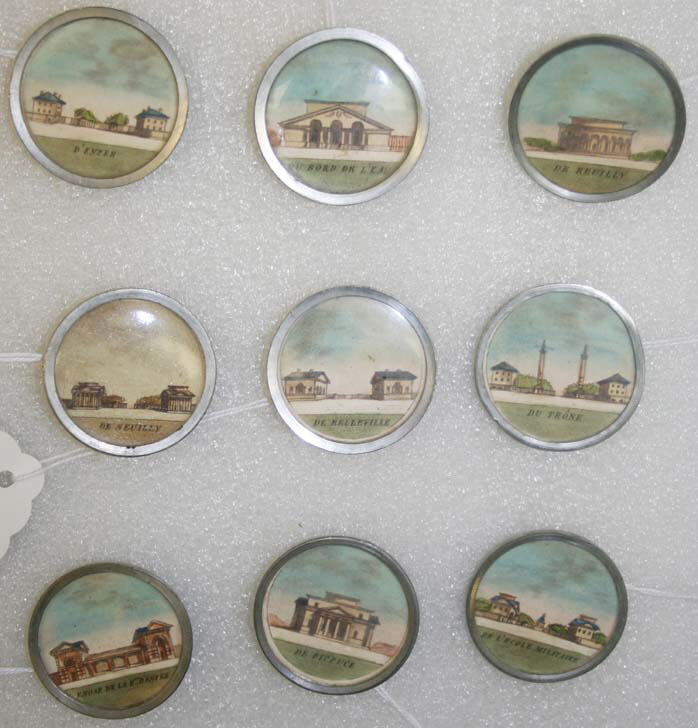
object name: button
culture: french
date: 1780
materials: watercolor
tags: buildings